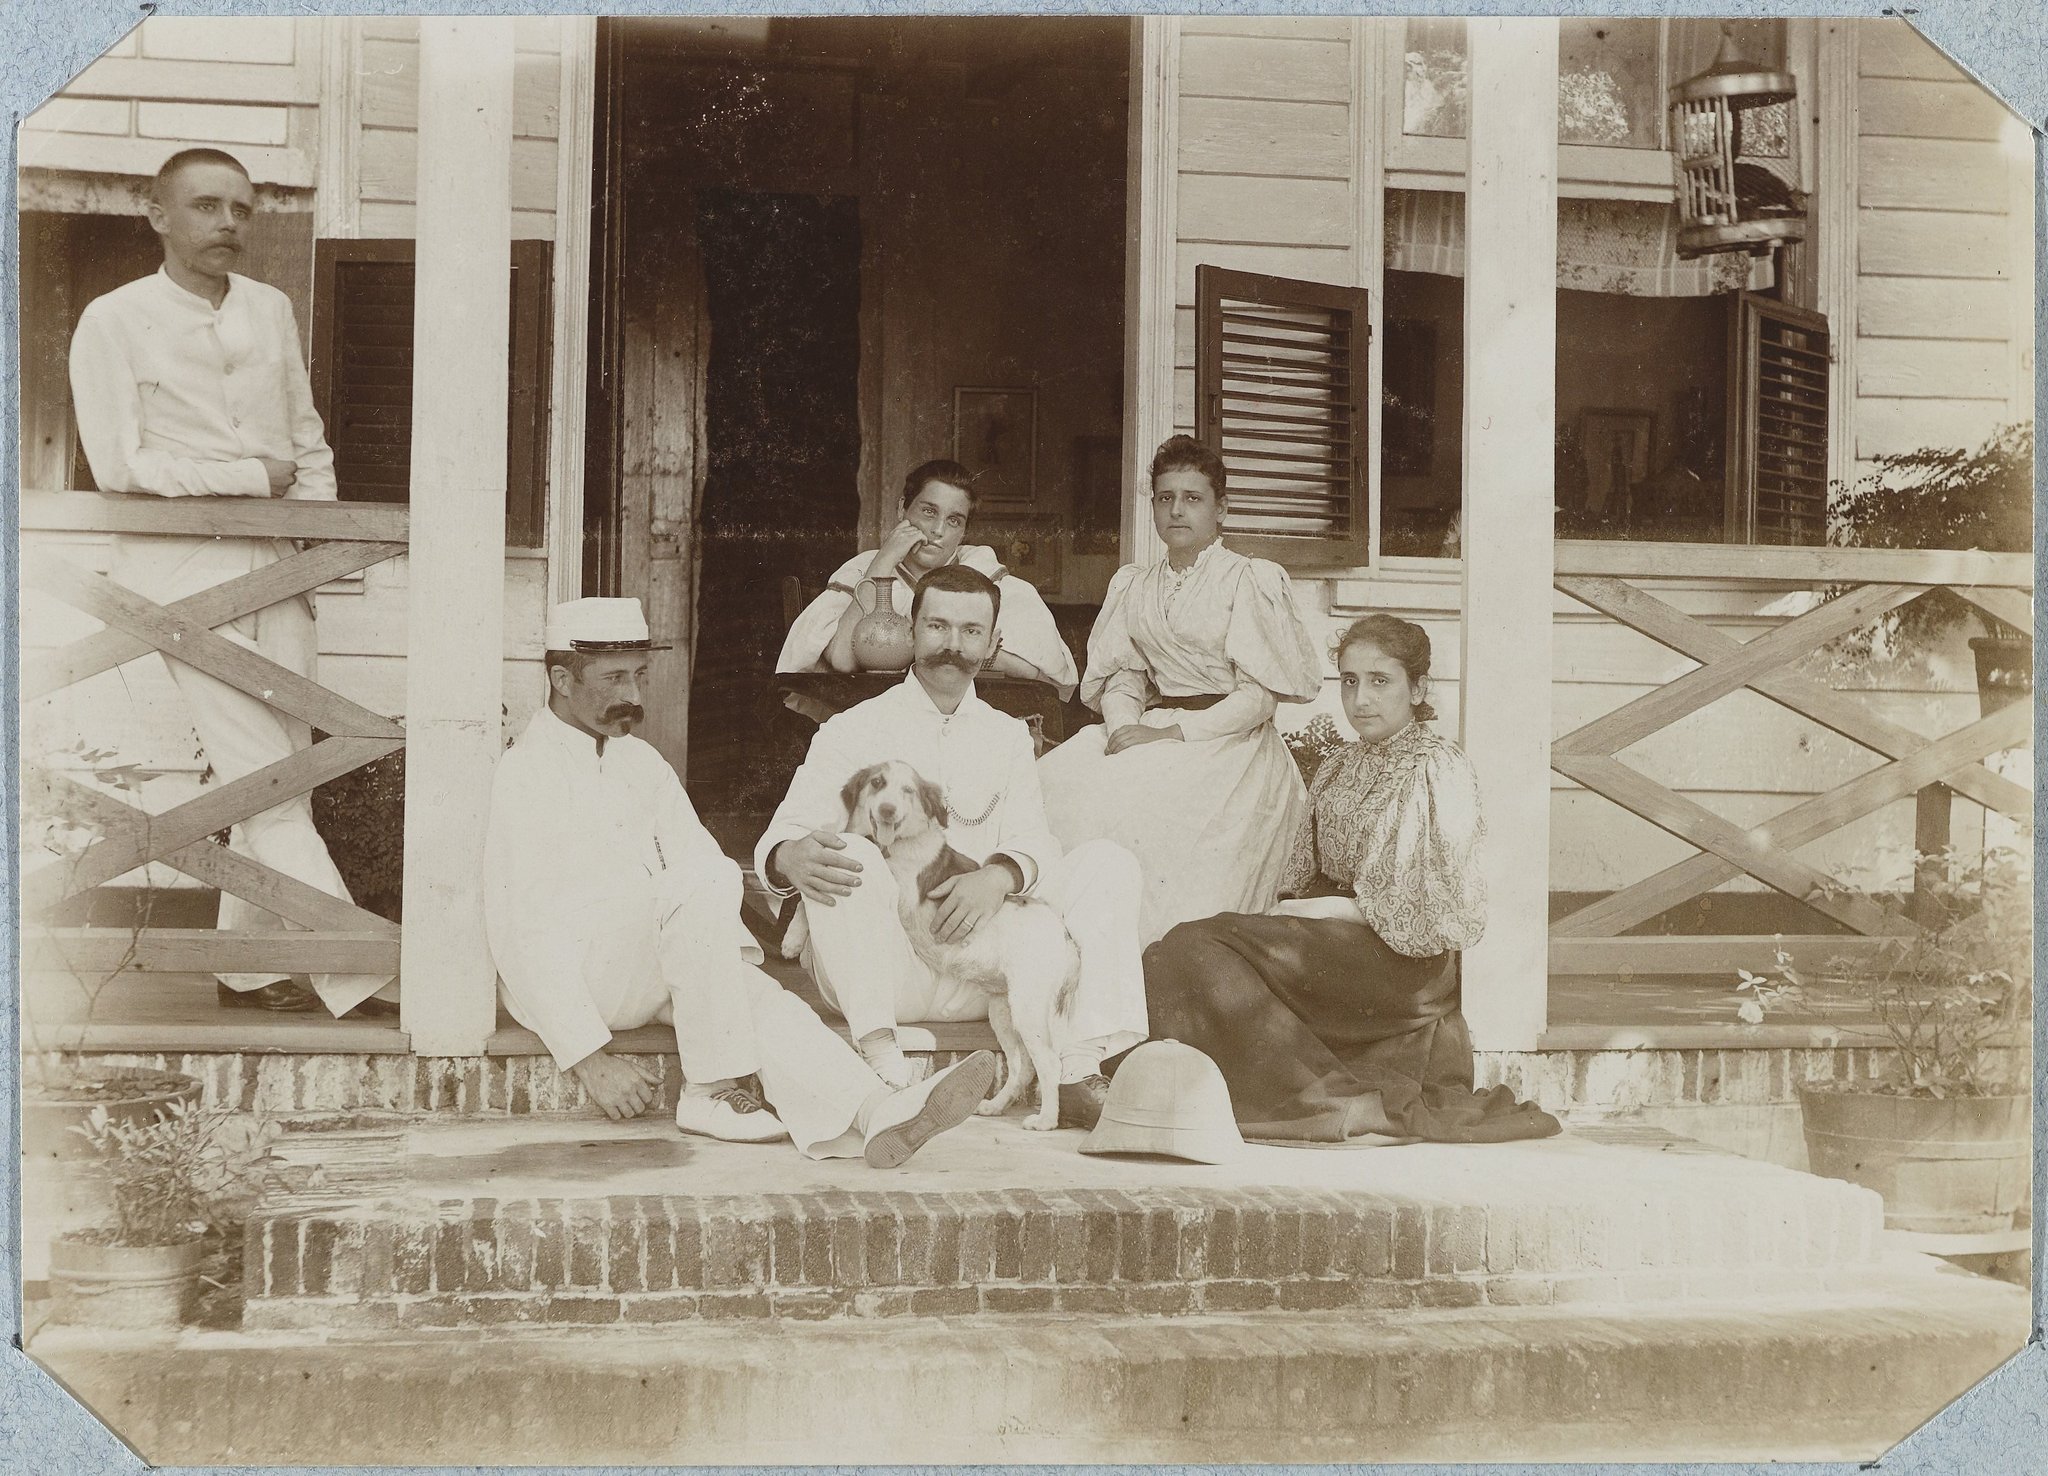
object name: photograph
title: Groepsfoto voor de woning in Fort Zeelandia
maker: théodore van lelyveld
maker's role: painter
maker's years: 1867-1954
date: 1896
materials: photographic support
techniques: collodion silver print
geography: suriname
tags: nijmegen, painter, théodore van lelyveld, garrison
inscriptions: inscription: ‘A.S. de Jongh. 1e Luit. Adj. / Toddy / Mej. L. Charlouis / J.A. Herman. 2e Luit.t. / Mej. Z. Charlouis.’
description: Groepsfoto van het echtpaar Lelyveld met vrienden op de trappen van hun huis in Fort Zeelandia te Paramaribo, tussen maart 1896 en mei 1898. In het midden Théodore met de hond Toddy, daarachter Dolly. Links de twee militairen J.A. Herman en A.S. de Jongh. Rechts de twee mejuffrouwen Z. en L. Charlouis. Fotoafdruk in een fotoalbum van Théodore van Lelyveld over Suriname uit 1895-1898.